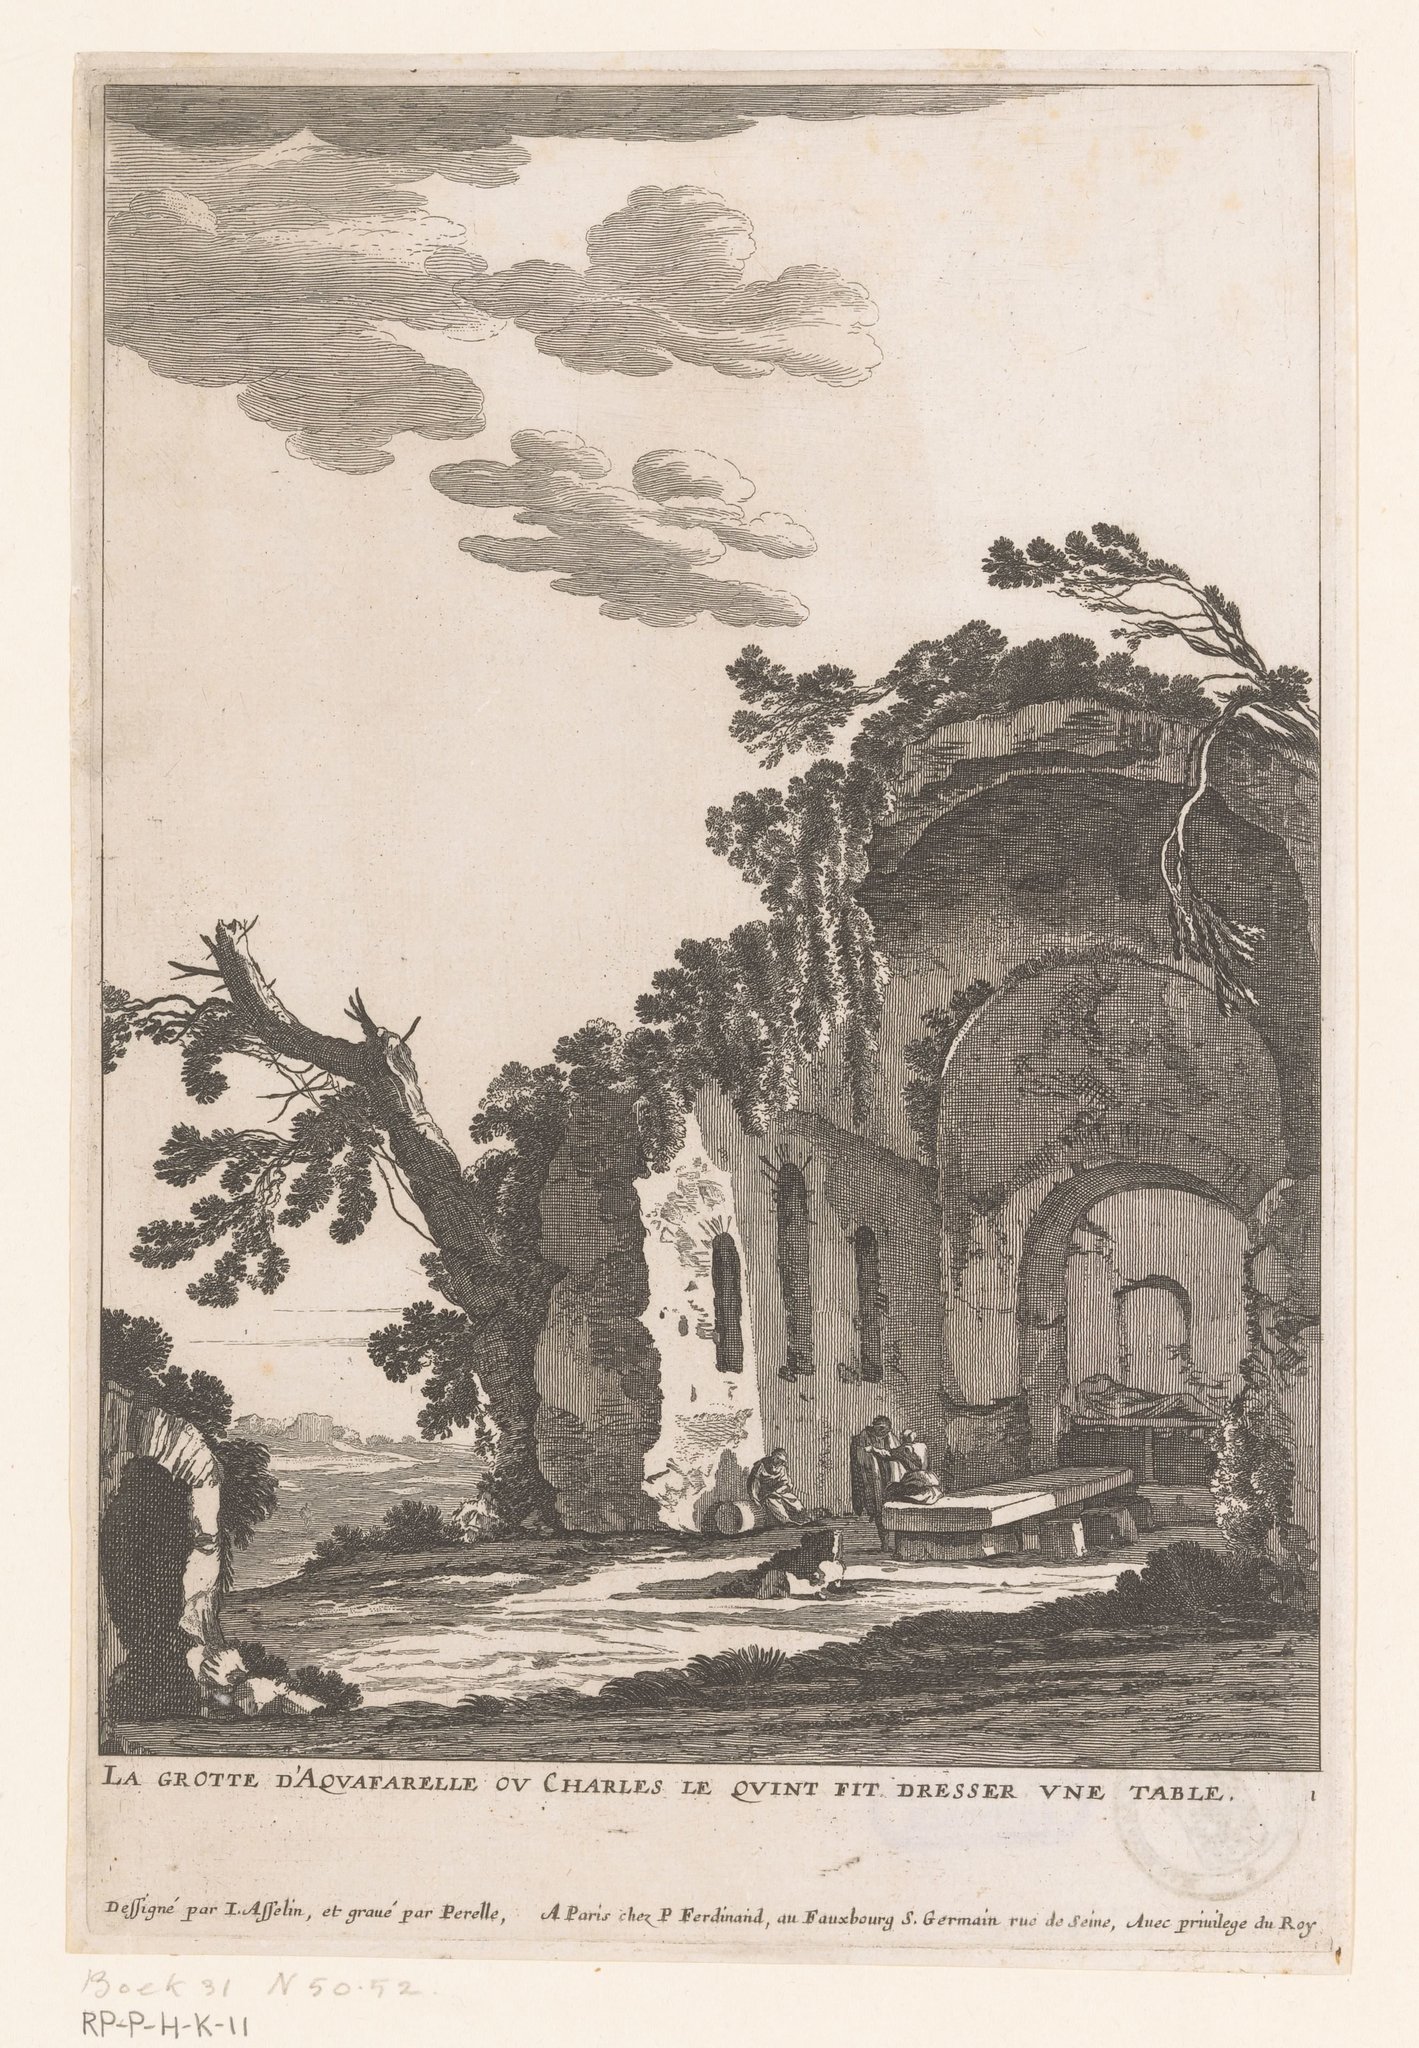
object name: print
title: Grot van de nimf Egeria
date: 1655-1672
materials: paper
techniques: engraving, etching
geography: paris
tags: landscape with ruins, rome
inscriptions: collector's mark: Lugt 10, collector's mark: Lugt 11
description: Prenten met het signatuur 'Perelle' kunnen zowel door vader Gabriel als door zonen Nicolas en Adam gemaakt zijn.